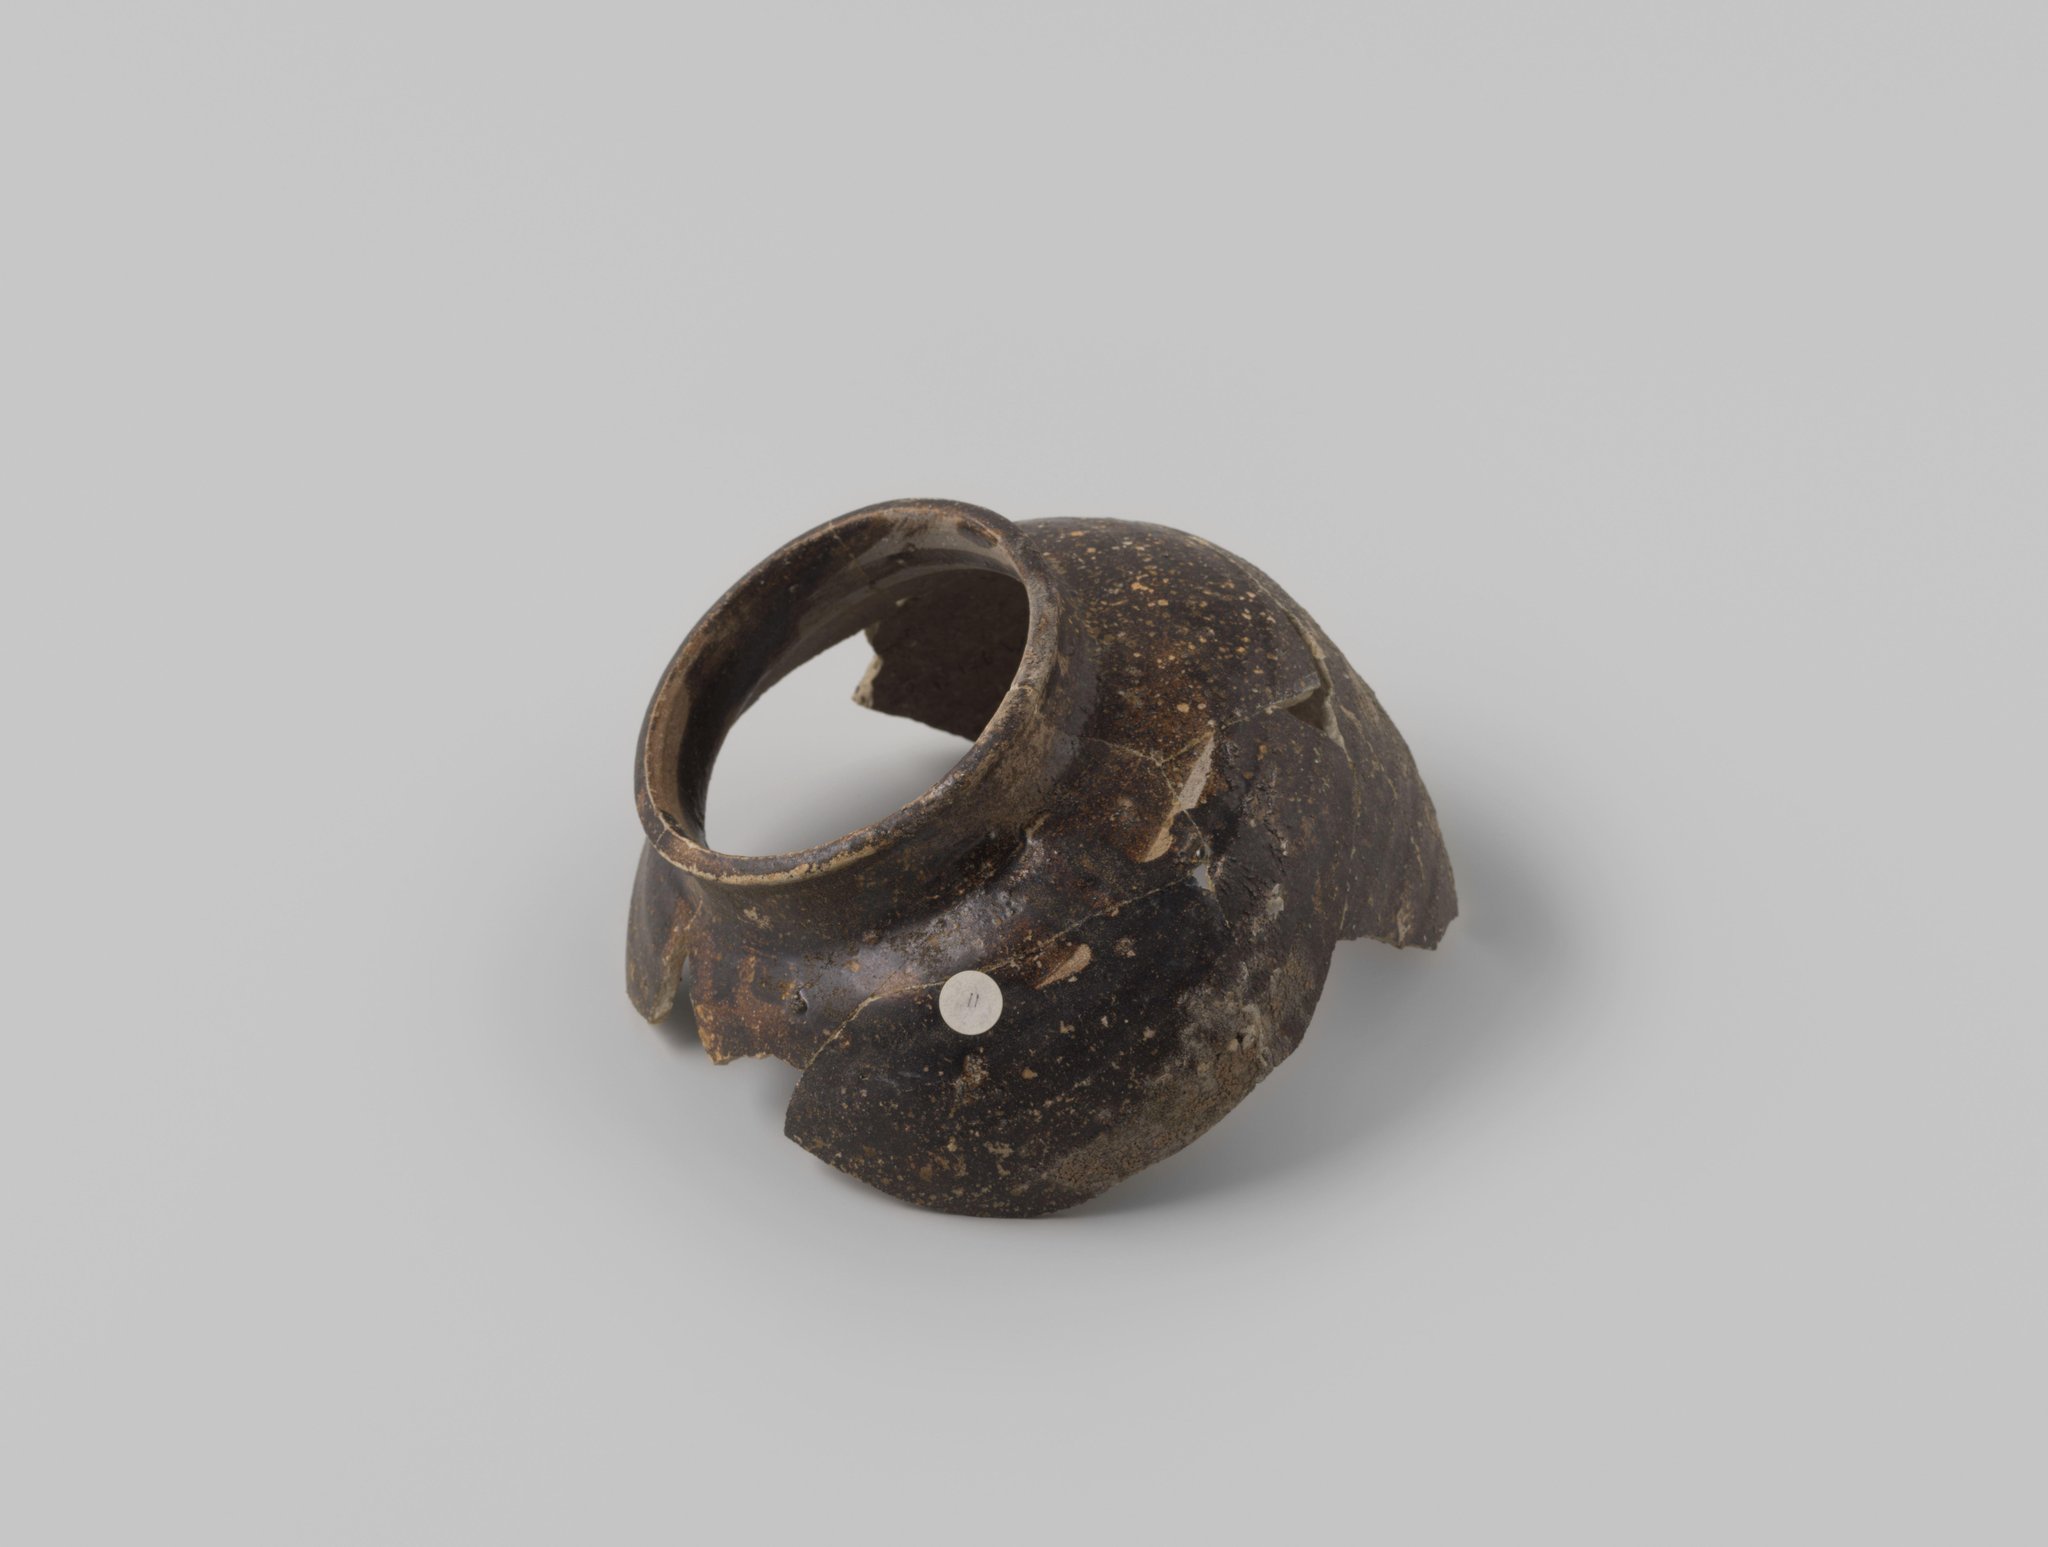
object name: martavaan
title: Martavaan uit V.O.C.-schip de 'Witte Leeuw'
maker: Anonymous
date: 1613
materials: porcelain, stoneware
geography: southeast asia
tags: verenigde oostindische compagnie, sint-helena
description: A jar. The stoneware body is grey and cream coloured and has few black and white impurities. The spotted, sepia-coloured glaze covers the outside entirely and the inside of the lip and neck. From there, glaze drippings run out to the shoulder. The remainder of the inside of the jar is covered with a thin, brown coloured glaze. The lower part of the body has horizontal ripples as the jar has been made by the clay-coiling method.